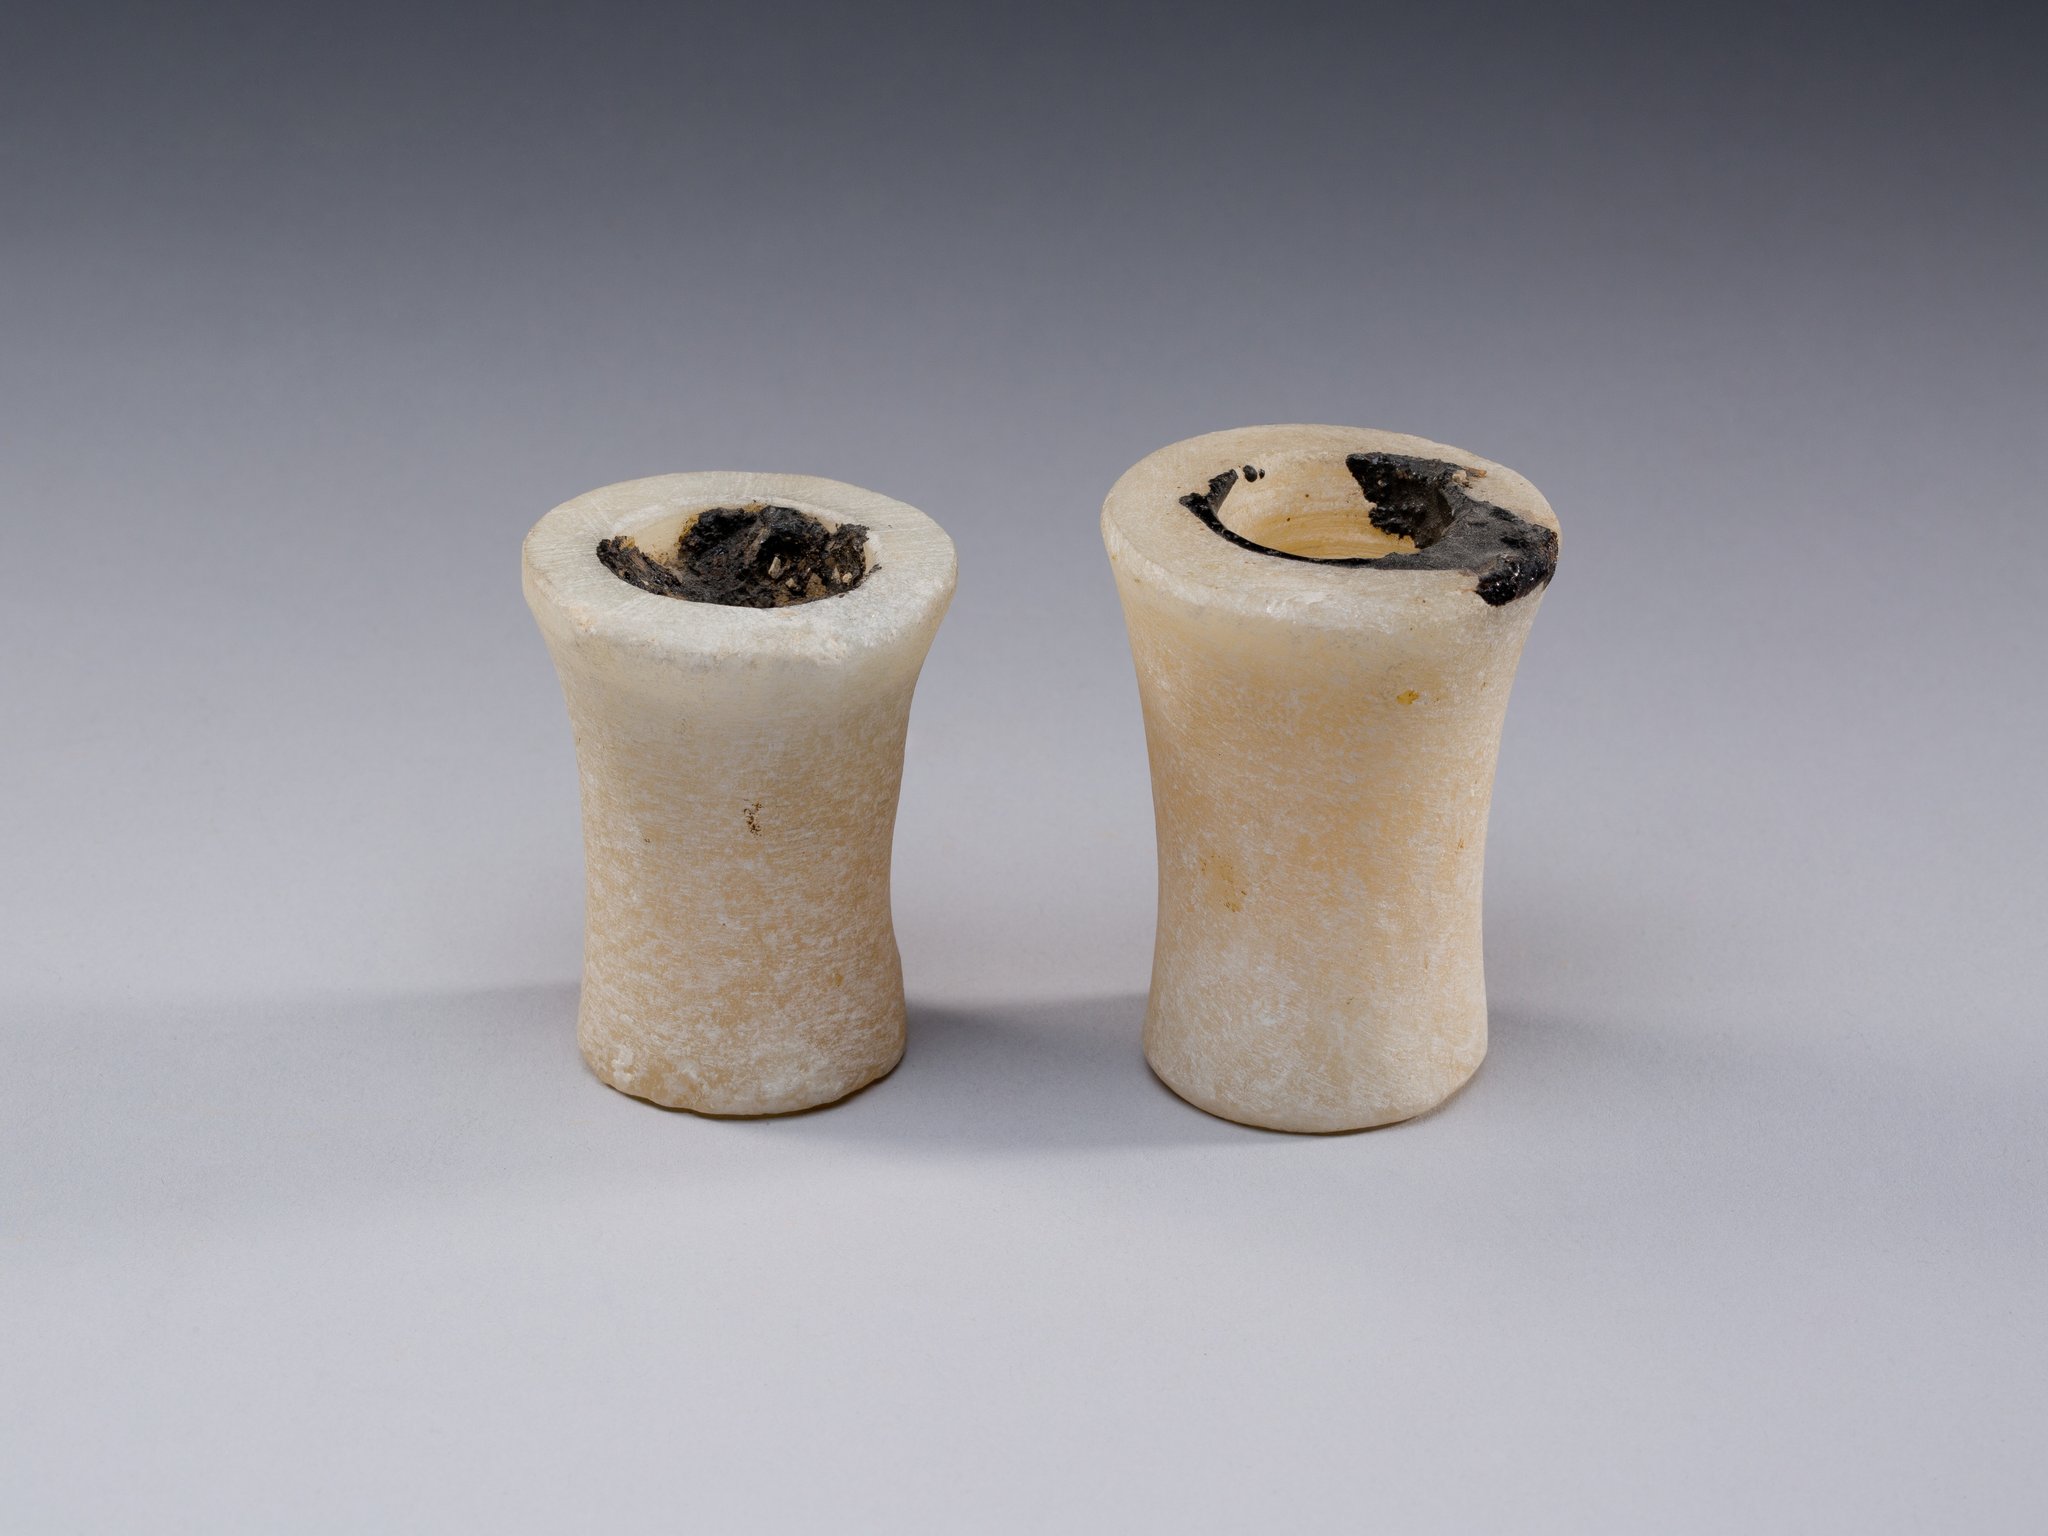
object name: ointment jar, model, senenmut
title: Model Ointment Jar from a Foundation Deposit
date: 1479-1458 BCE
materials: stone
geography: egypt